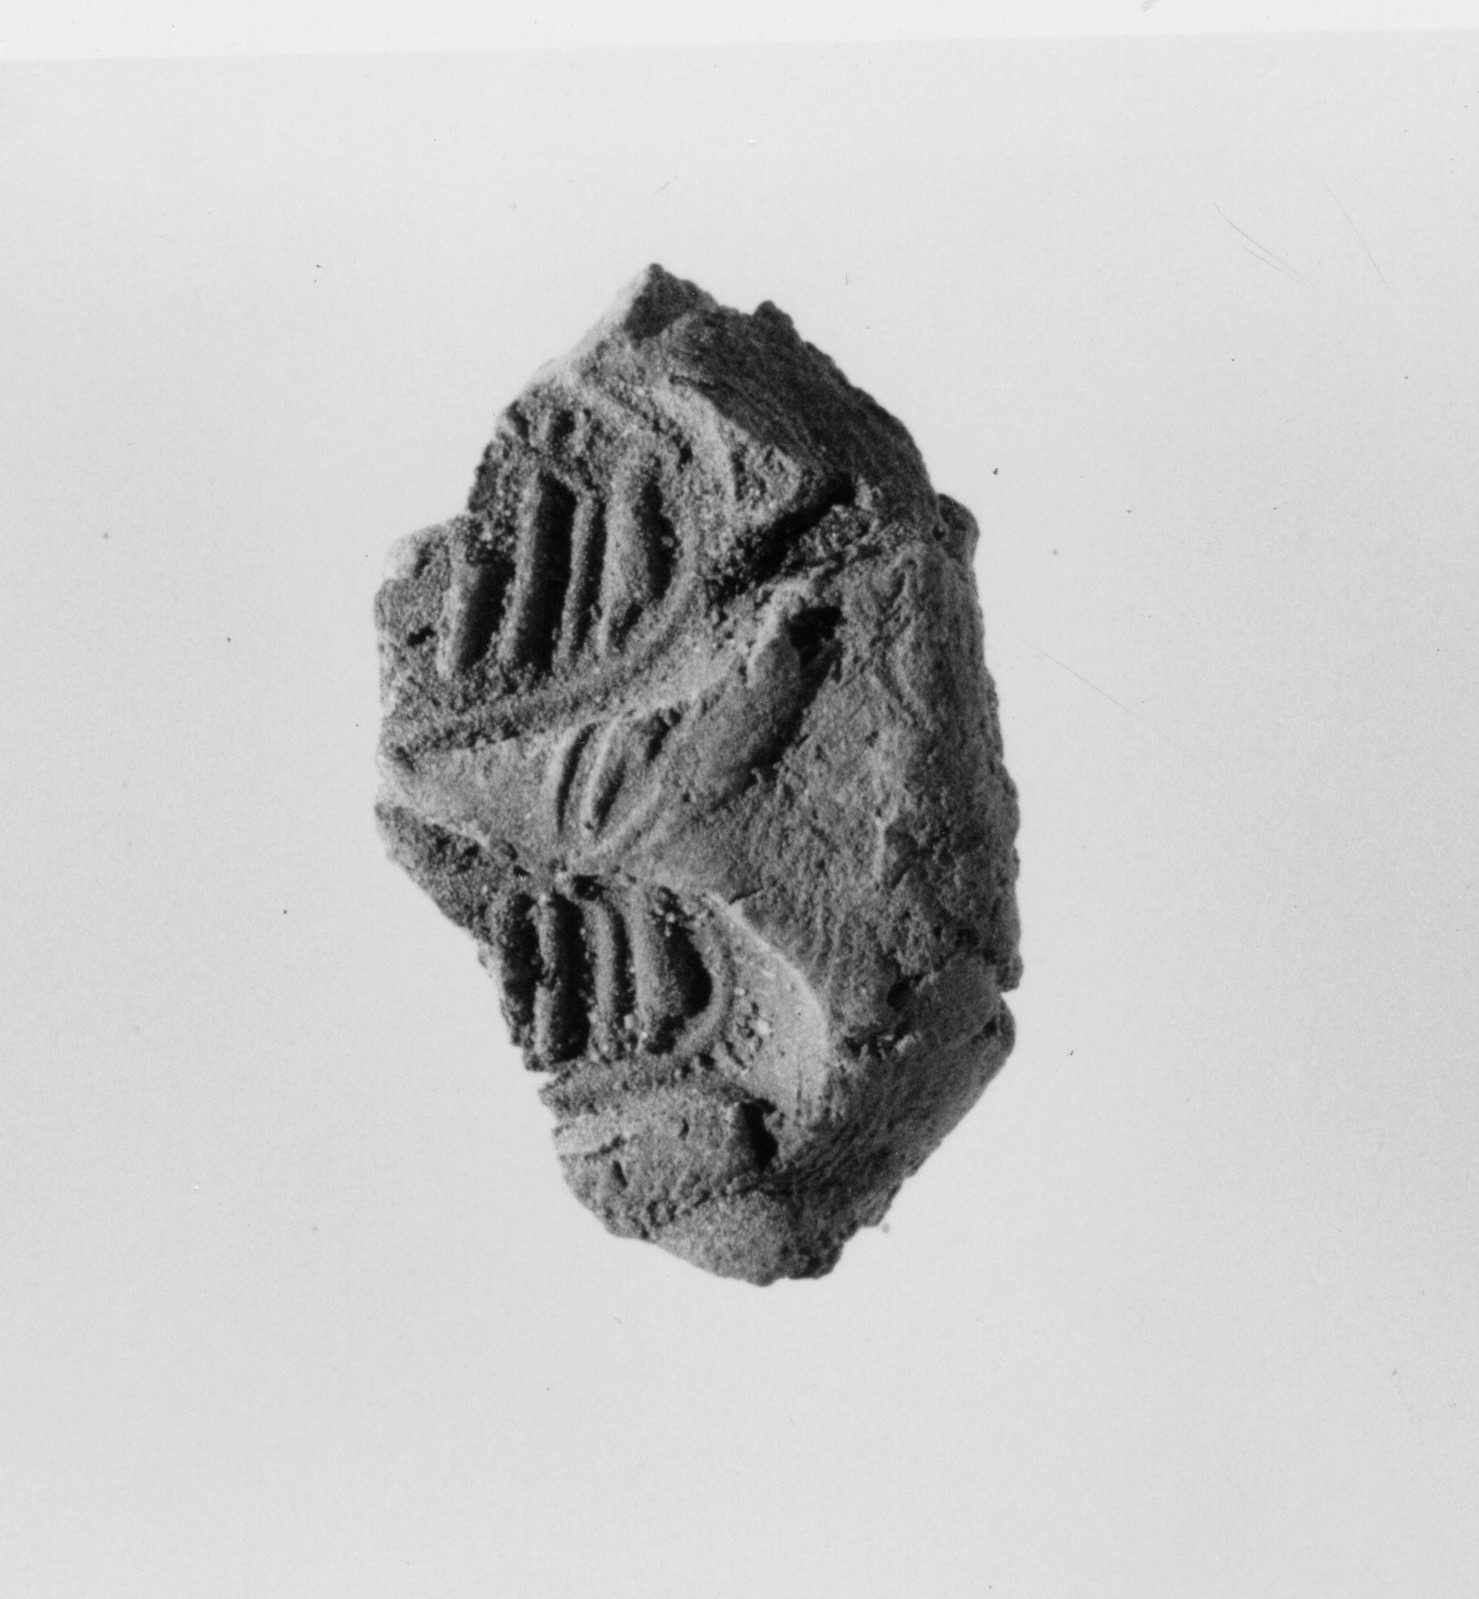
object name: sealing, amenhotep iii, nebmaatre, cobra, amun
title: Document Sealing With Multiple Seal Impressions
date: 1390-1352 BCE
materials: mud